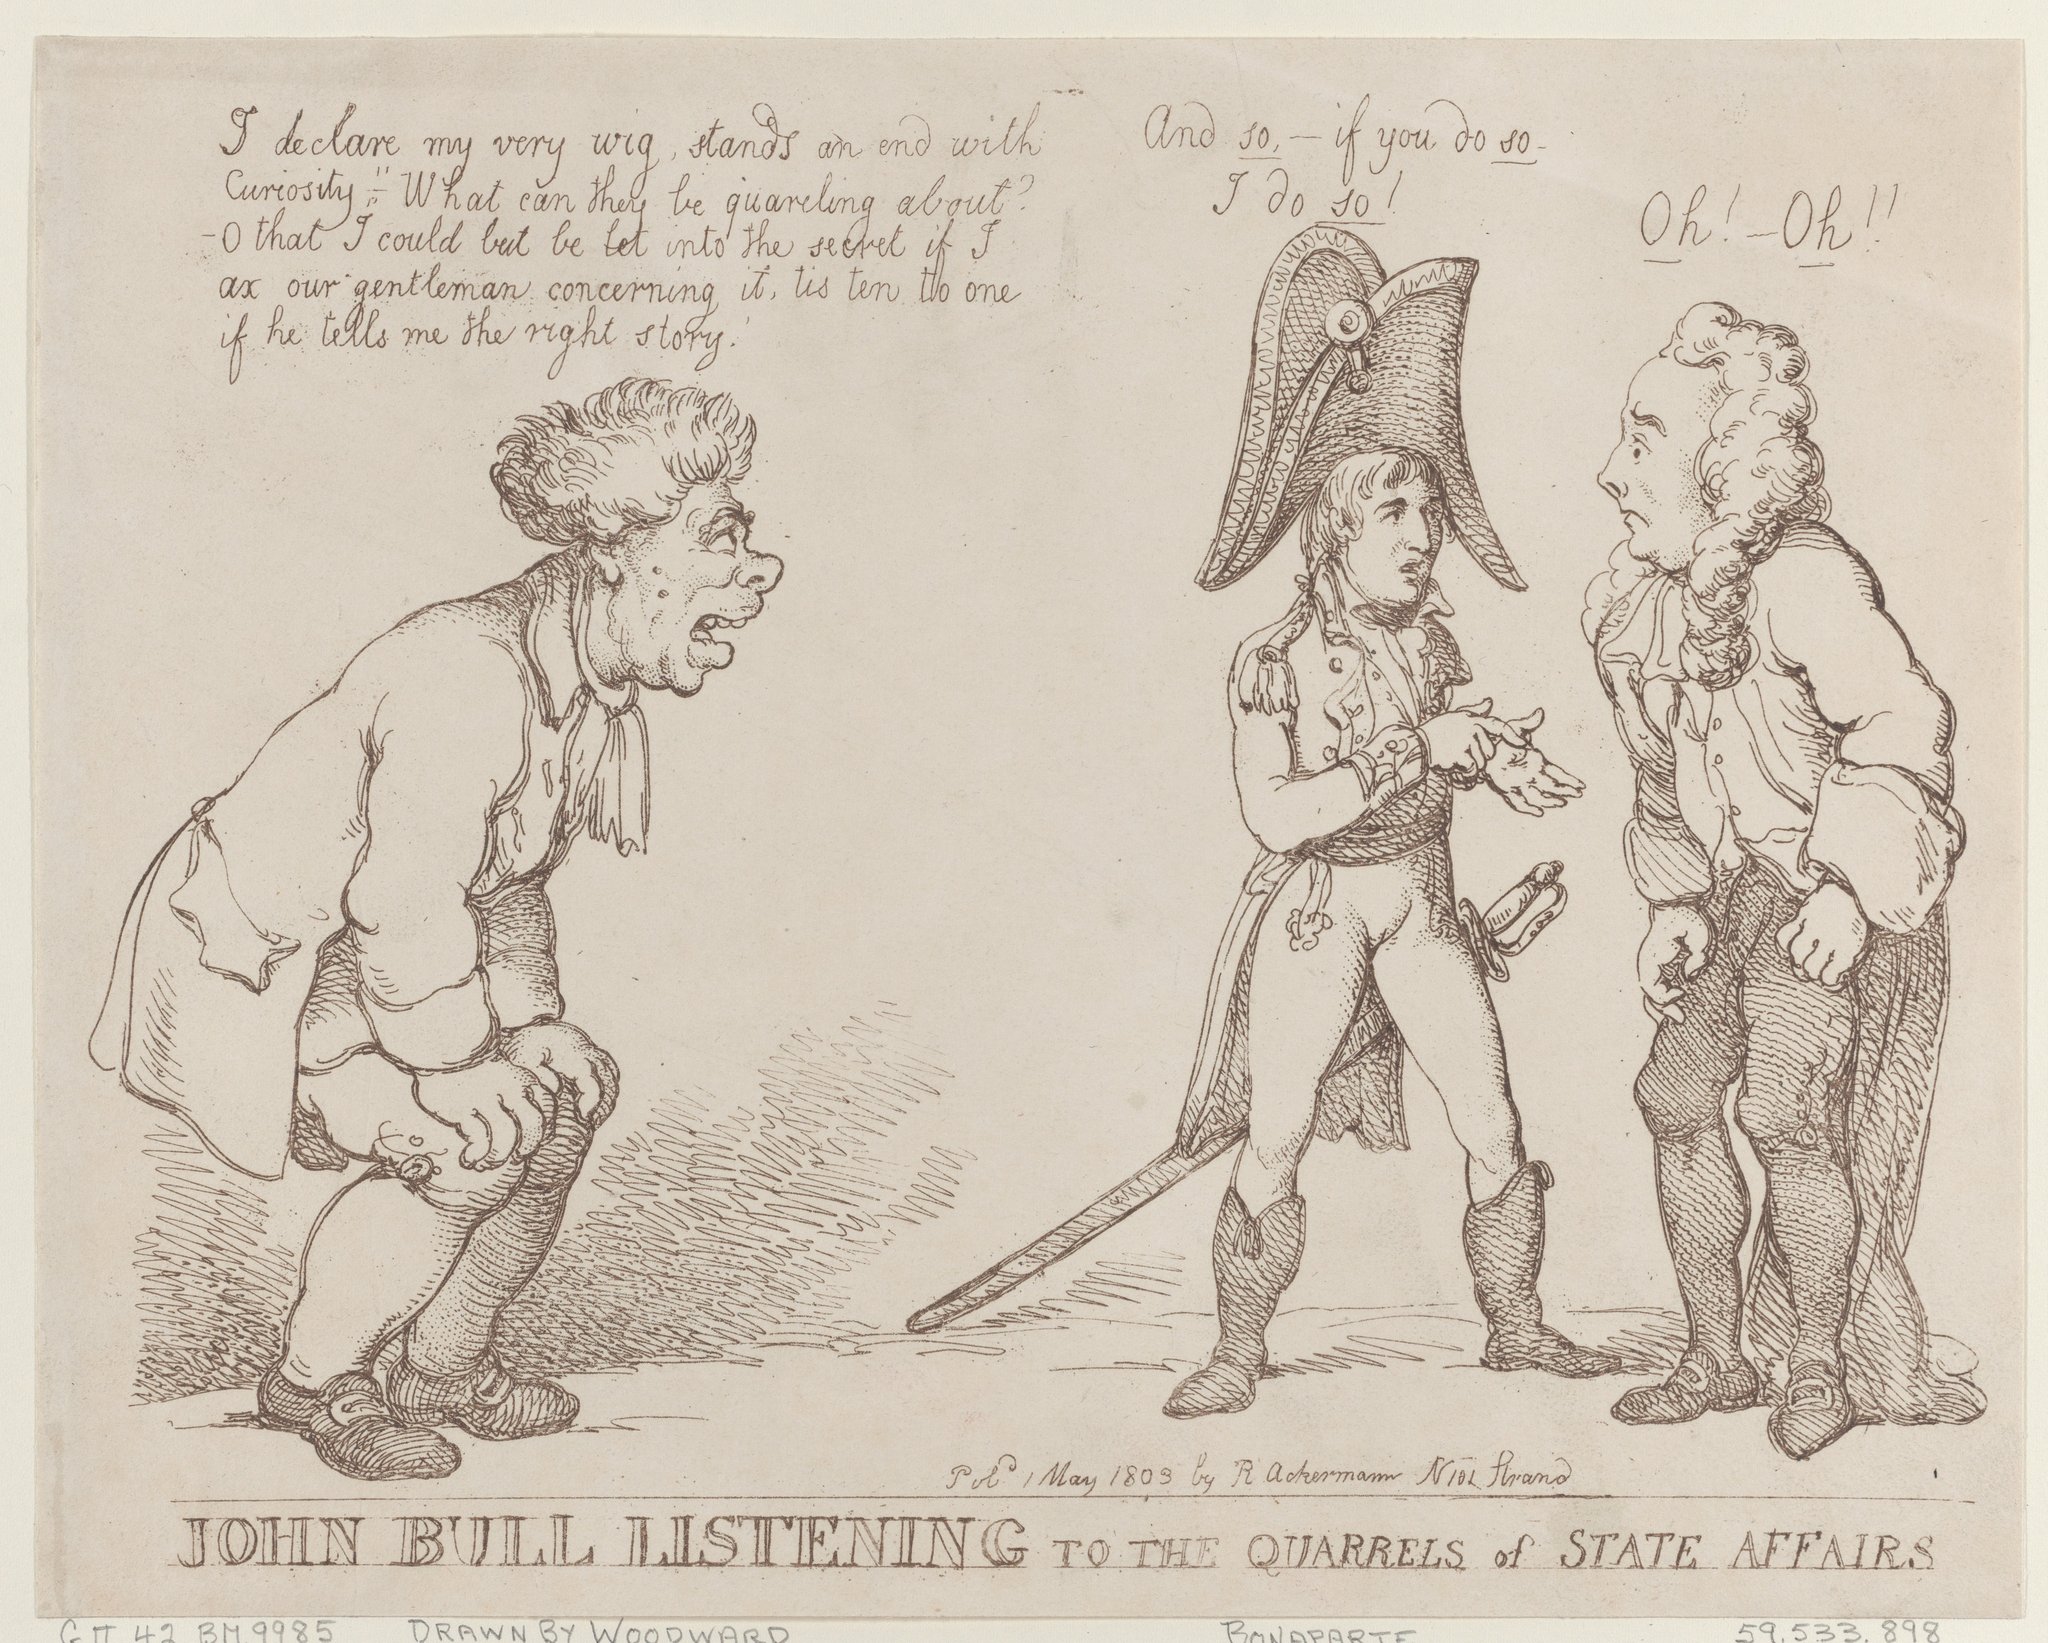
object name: print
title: John Bull Listening to the Quarrels of State Affairs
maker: thomas rowlandson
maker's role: artist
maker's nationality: british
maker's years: 1757-1827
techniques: etching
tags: satire,napoleon i,men,politics